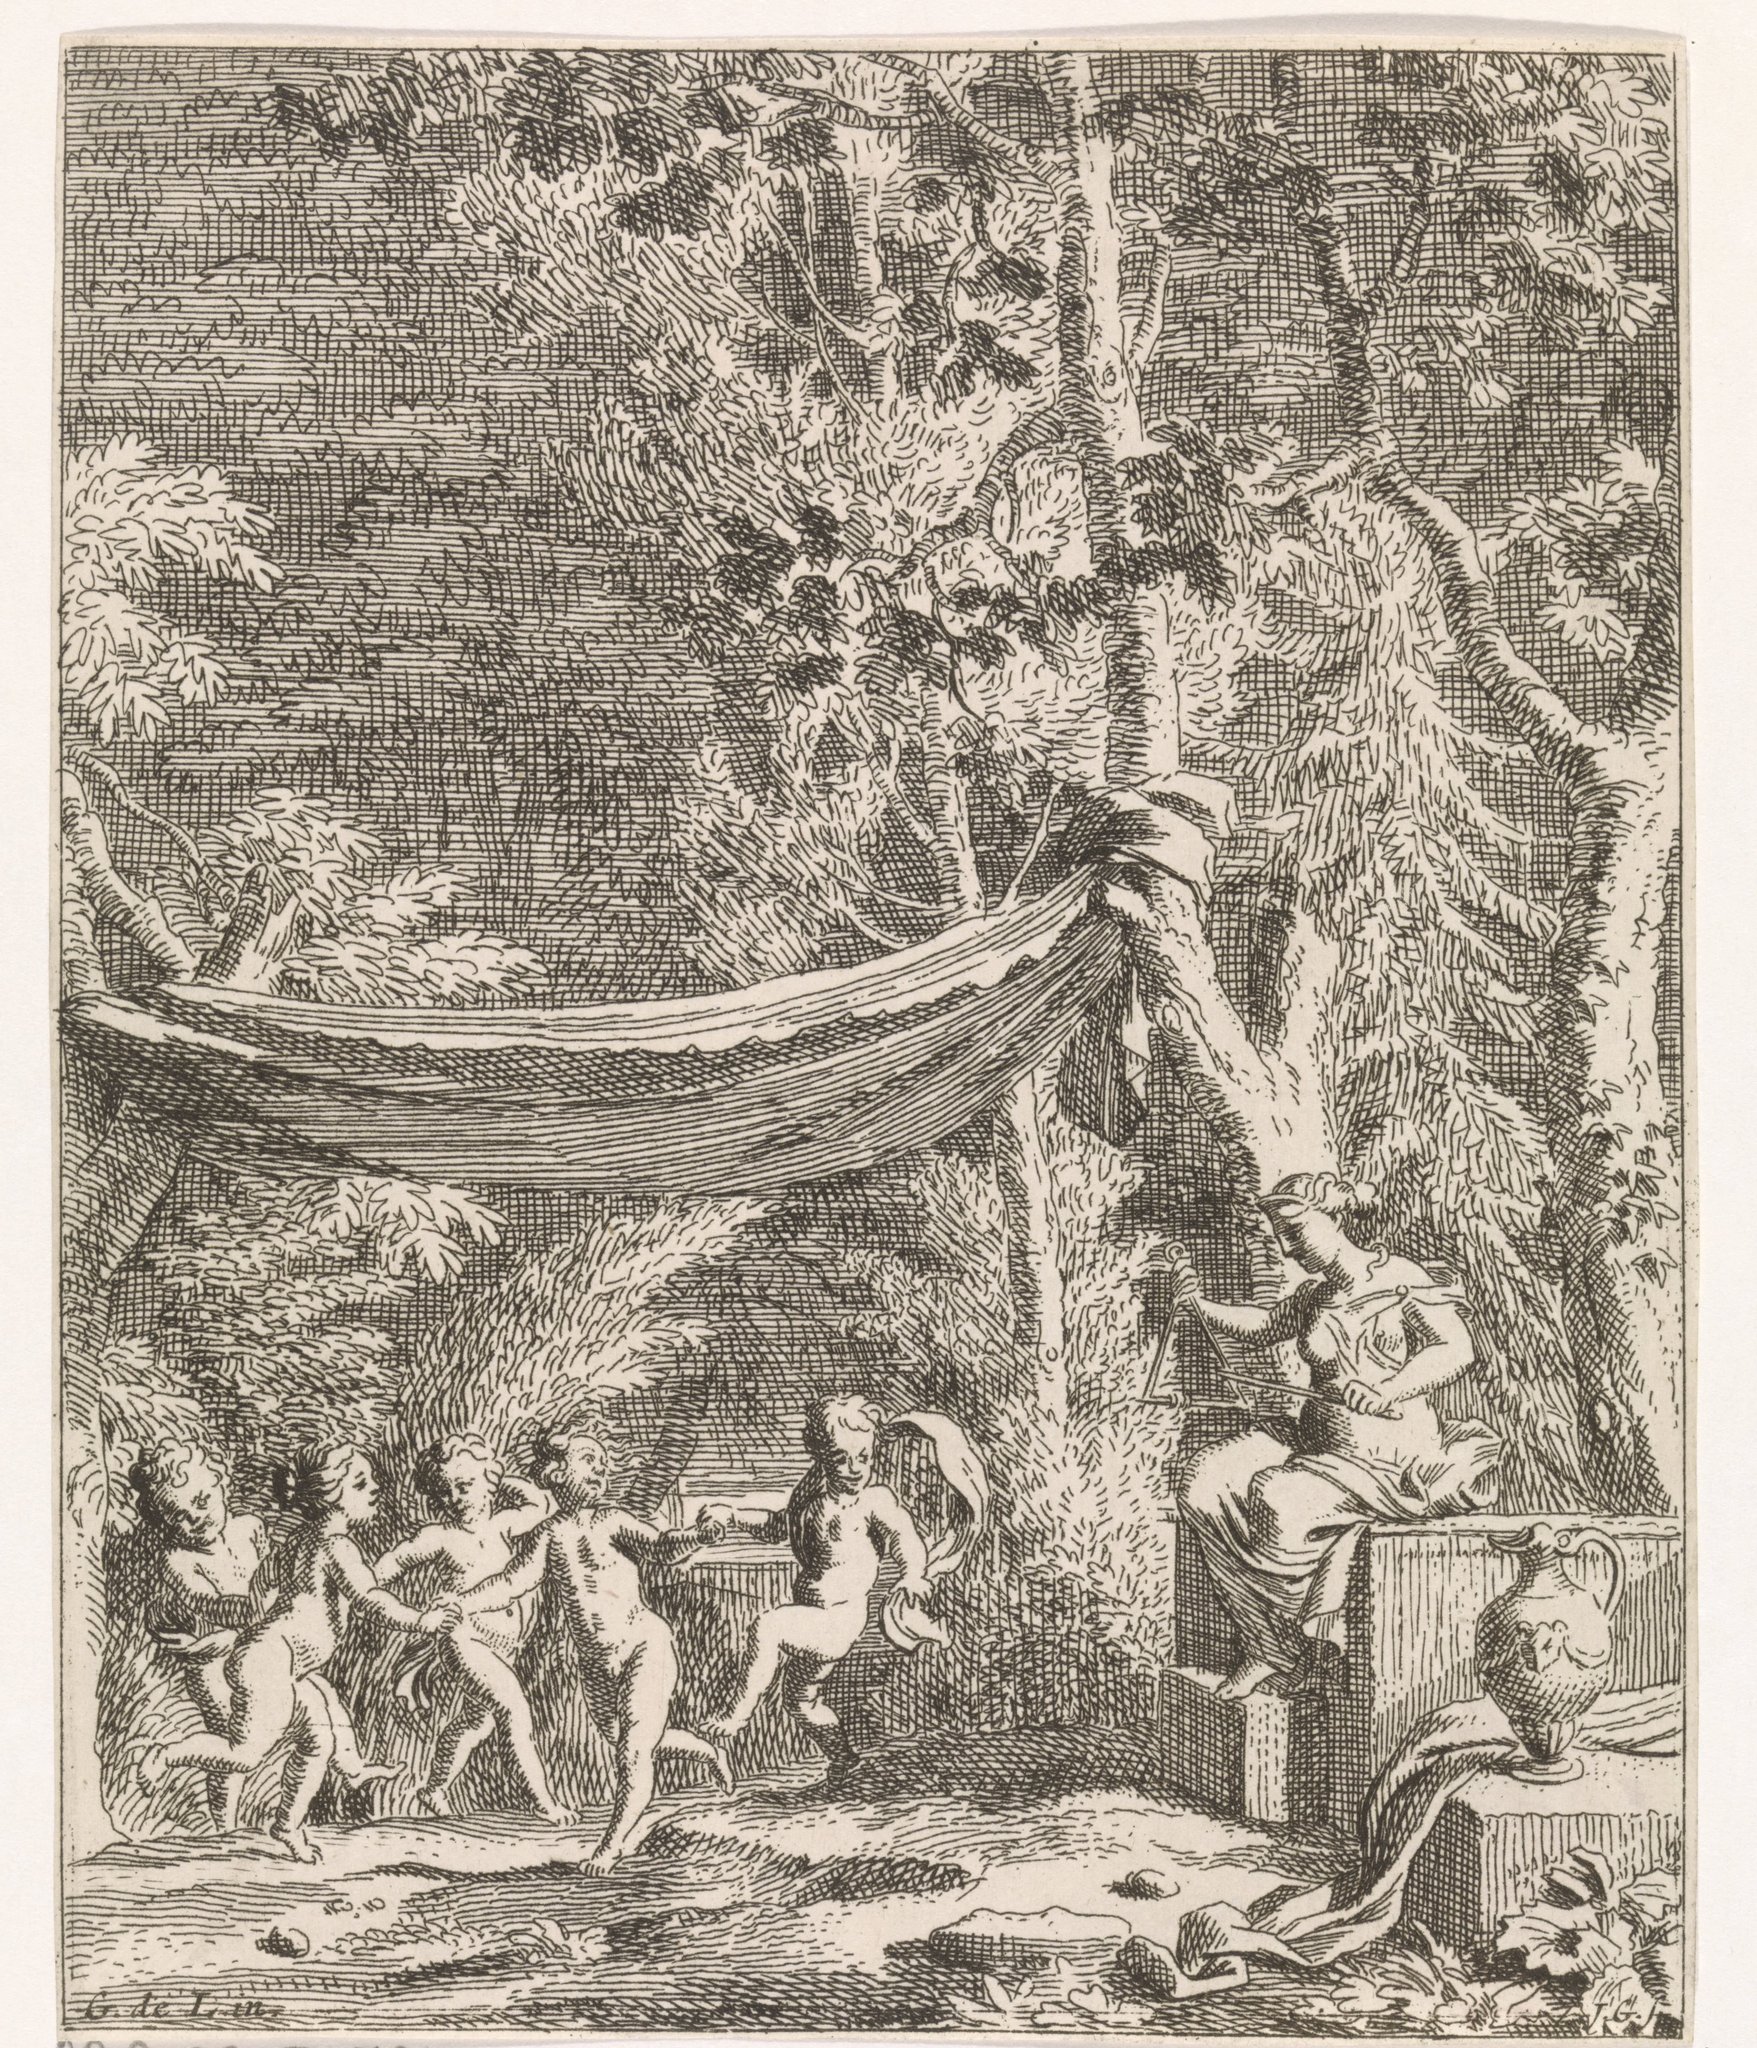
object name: print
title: Vijf putti dansen op de muziek van een triangel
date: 1656-1726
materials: paper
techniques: etching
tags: group dancing, other percussion instruments (with name), cupids: 'amores', 'amoretti', 'putti'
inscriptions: collector's mark: Lugt 240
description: Rechts speelt een vrouw op een triangel. Vijf putti dansen op de muziek. De prent maakt deel uit van een serie met mythologische en allegorische voorstellingen.